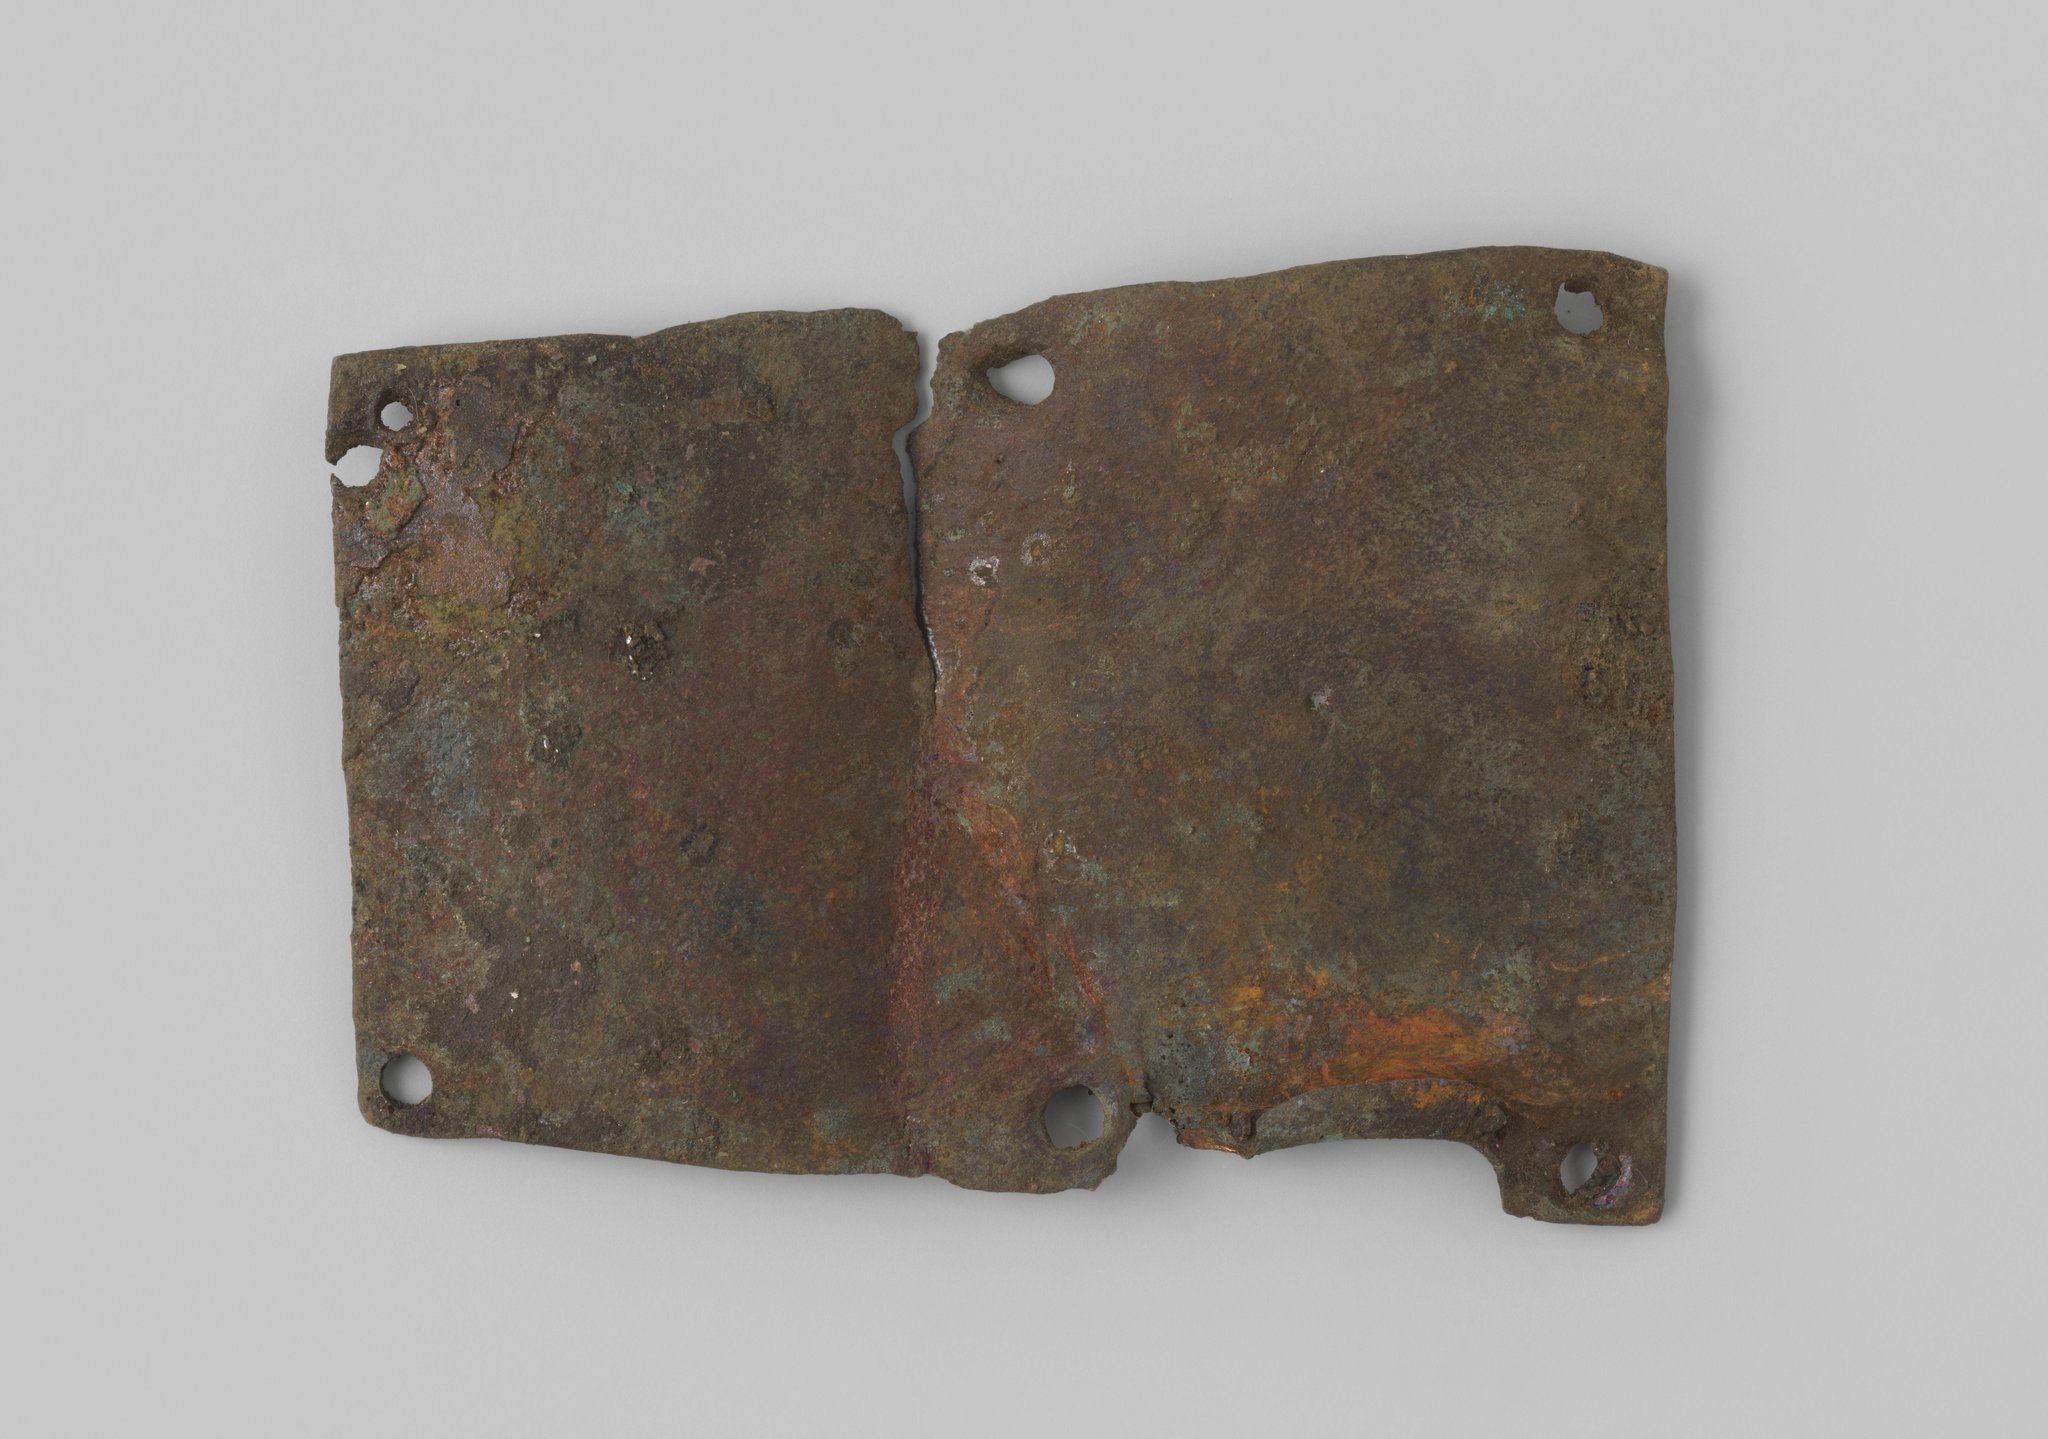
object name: musket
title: Kolfplaat van een musket uit het wrak van de Oost-Indiëvaarder Hollandia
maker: Anonymous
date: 1700-1743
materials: copper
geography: netherlands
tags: verenigde oostindische compagnie, hollandia (schip), annet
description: Musket, butt-plate; id. NG 1979-207H3071.